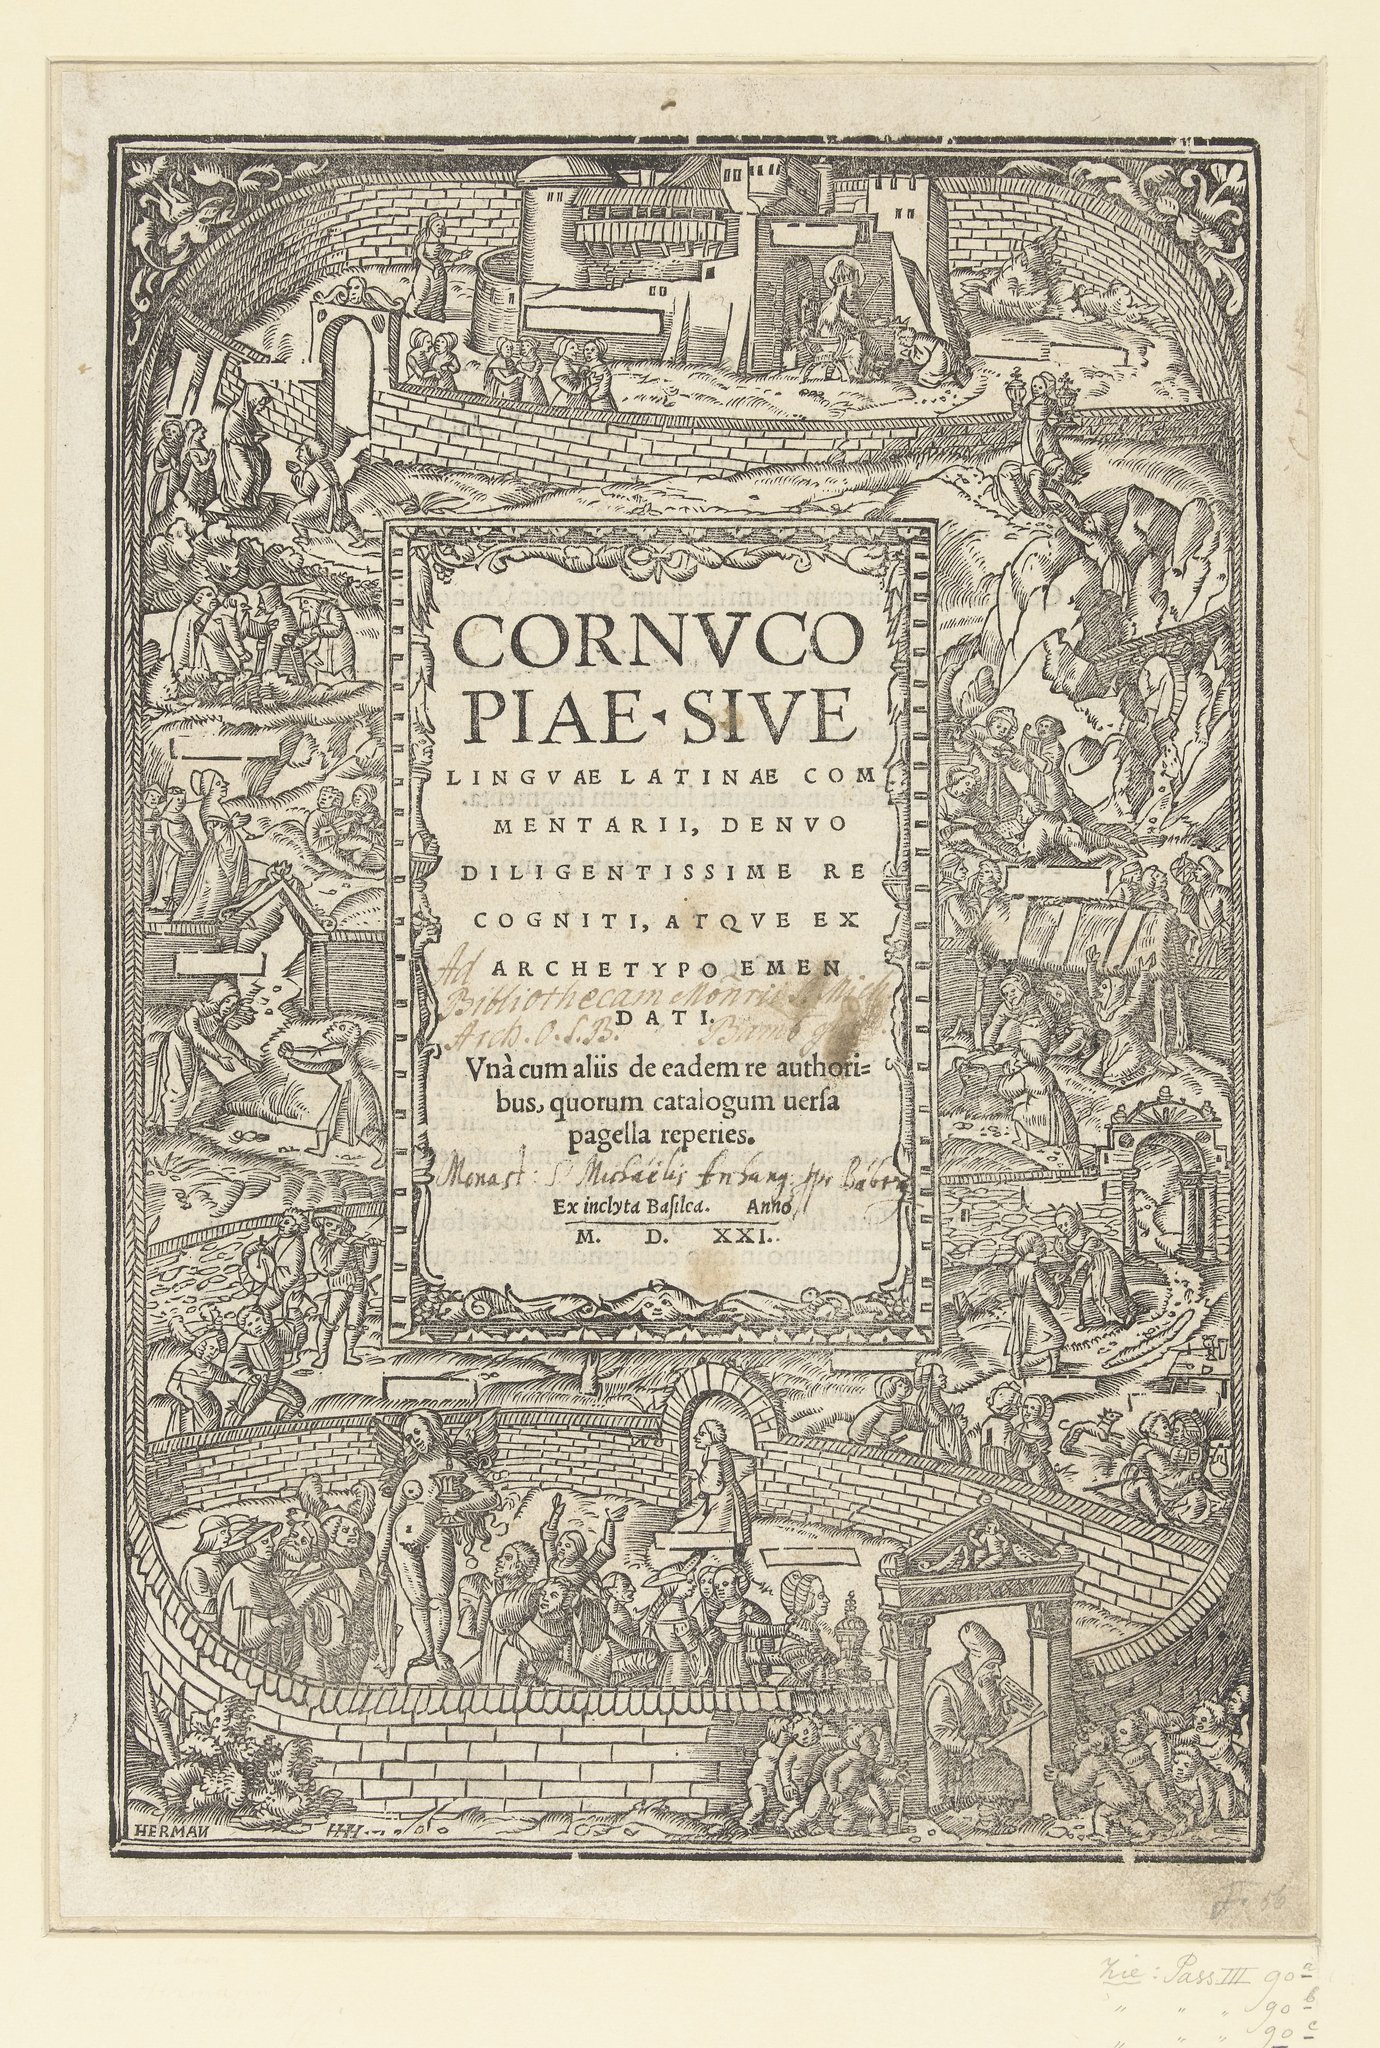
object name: book illustration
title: Titelprent met Tabula Cebetis en deugden en ondeugden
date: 1521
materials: paper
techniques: woodcut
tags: 'tabula cebetis'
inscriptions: collector's mark, collector's mark: Lugt 654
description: Titelprent met Tabula Cebetis. In een rechthoekige marge om de titel van het boek is een doolhofachtig pad naar de tempel van de deugd weergegeven. Het pad loopt via muren en poorten langs de deugden en ondeugden. De schildjes waarop hun namen zouden moeten staan zijn leeg. De titel staat in een rechthoekig kader met architectuur ornamenten: CORNU COPIAE SIVE ... uerfa pagella reperies. Op het verso staat de tekst van de inhoudsopgave in boekdruk.